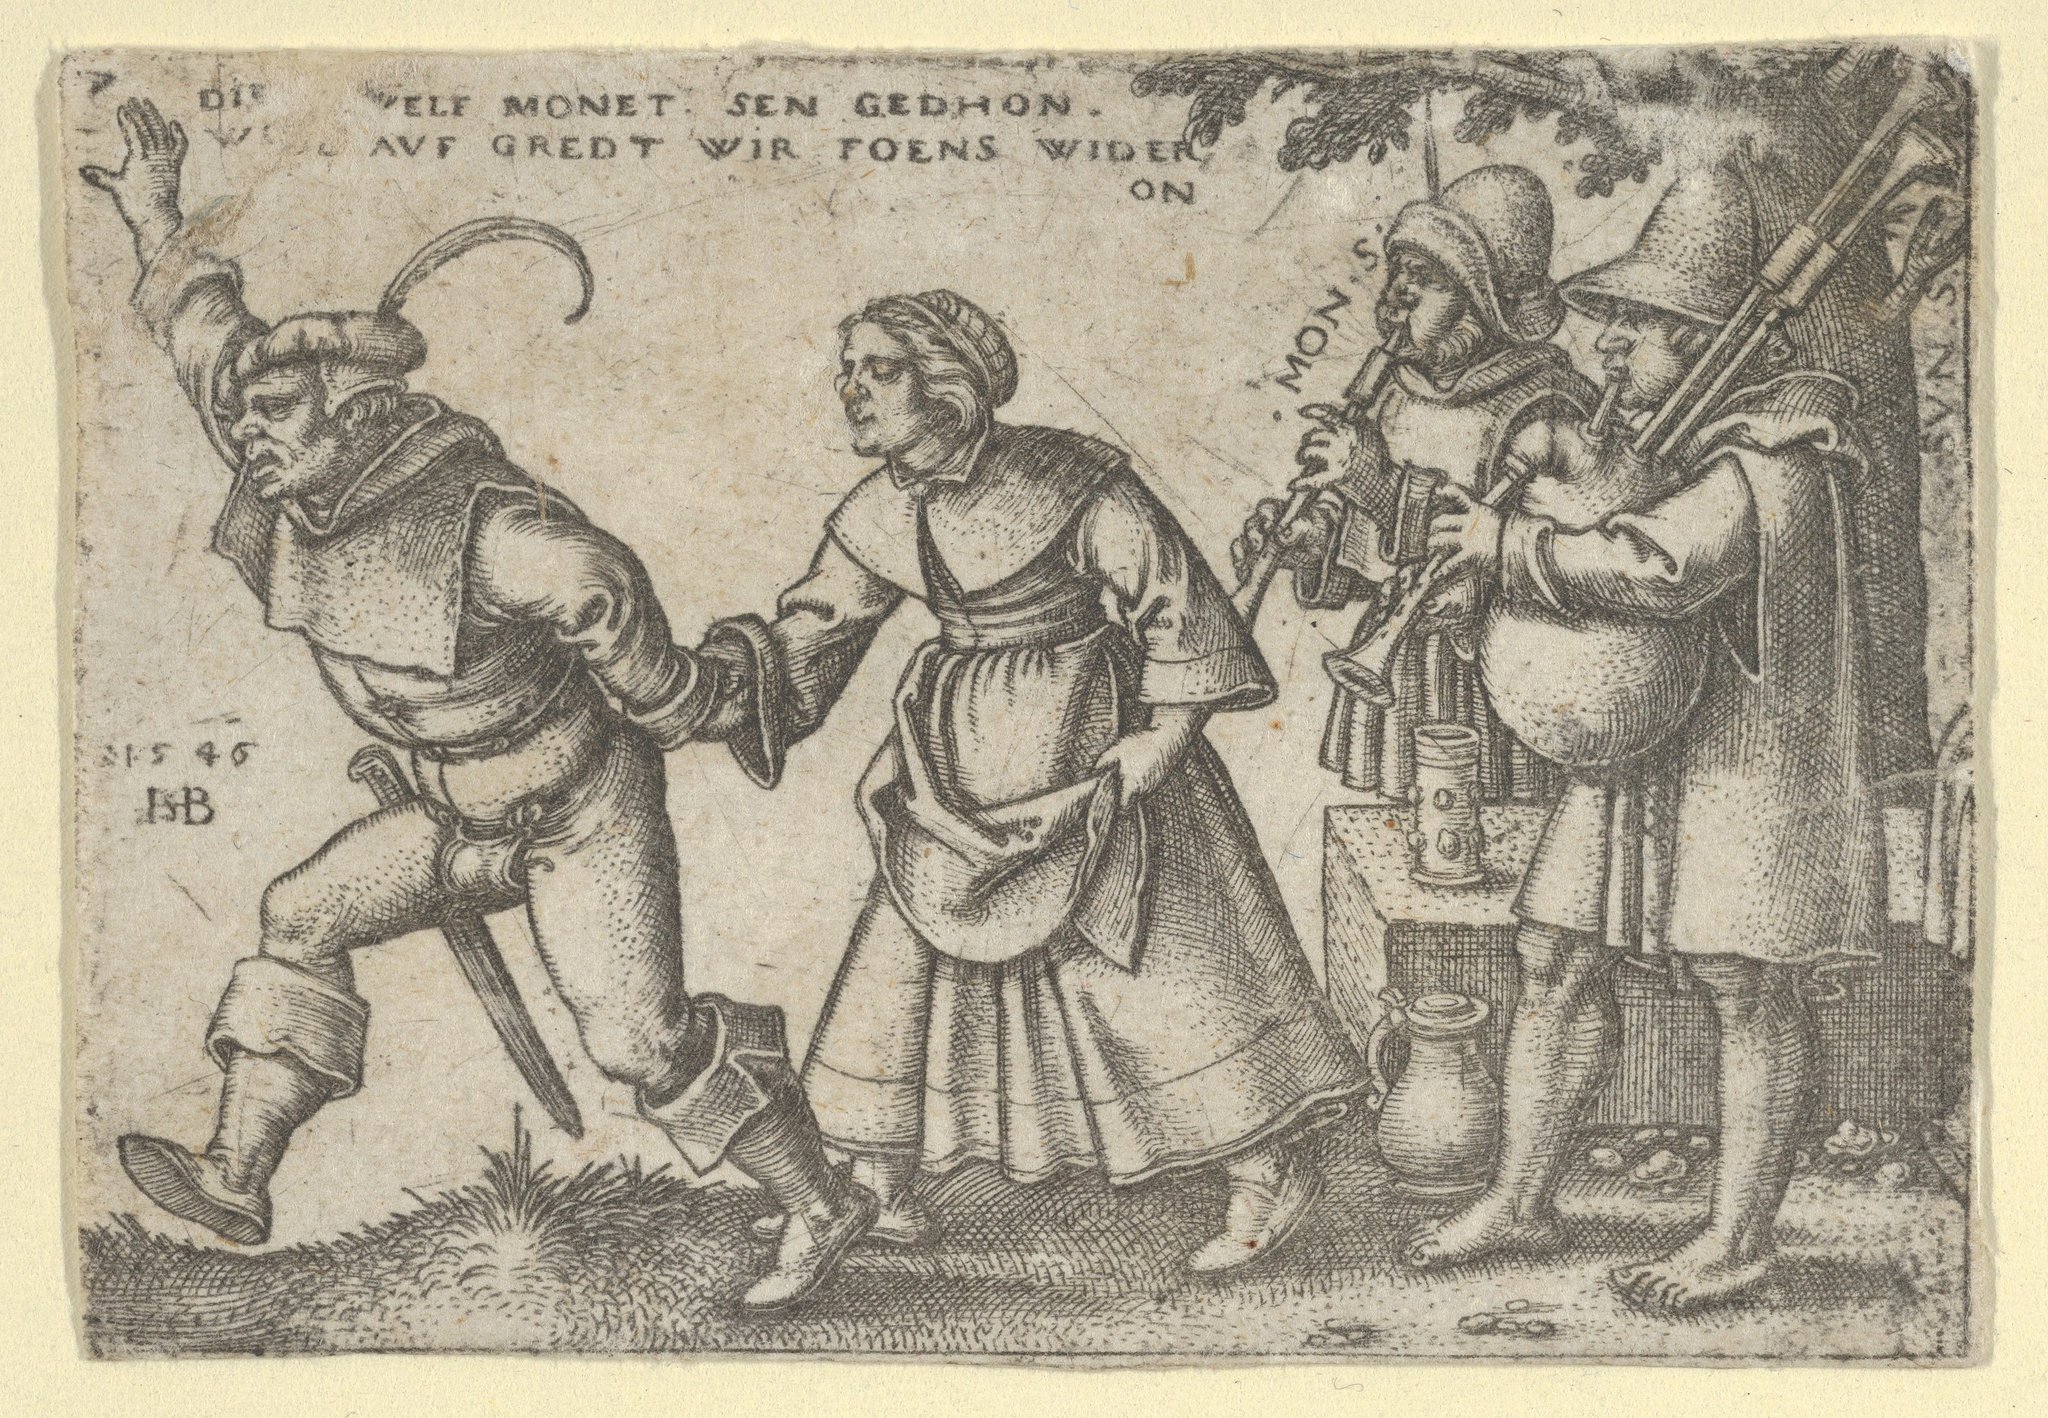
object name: print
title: The Year's End from "The Peasants' Feast" or "The Twelve Months"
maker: sebald beham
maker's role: artist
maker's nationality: german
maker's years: 1500-1550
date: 1546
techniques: engraving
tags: swords,men,women,bagpipes